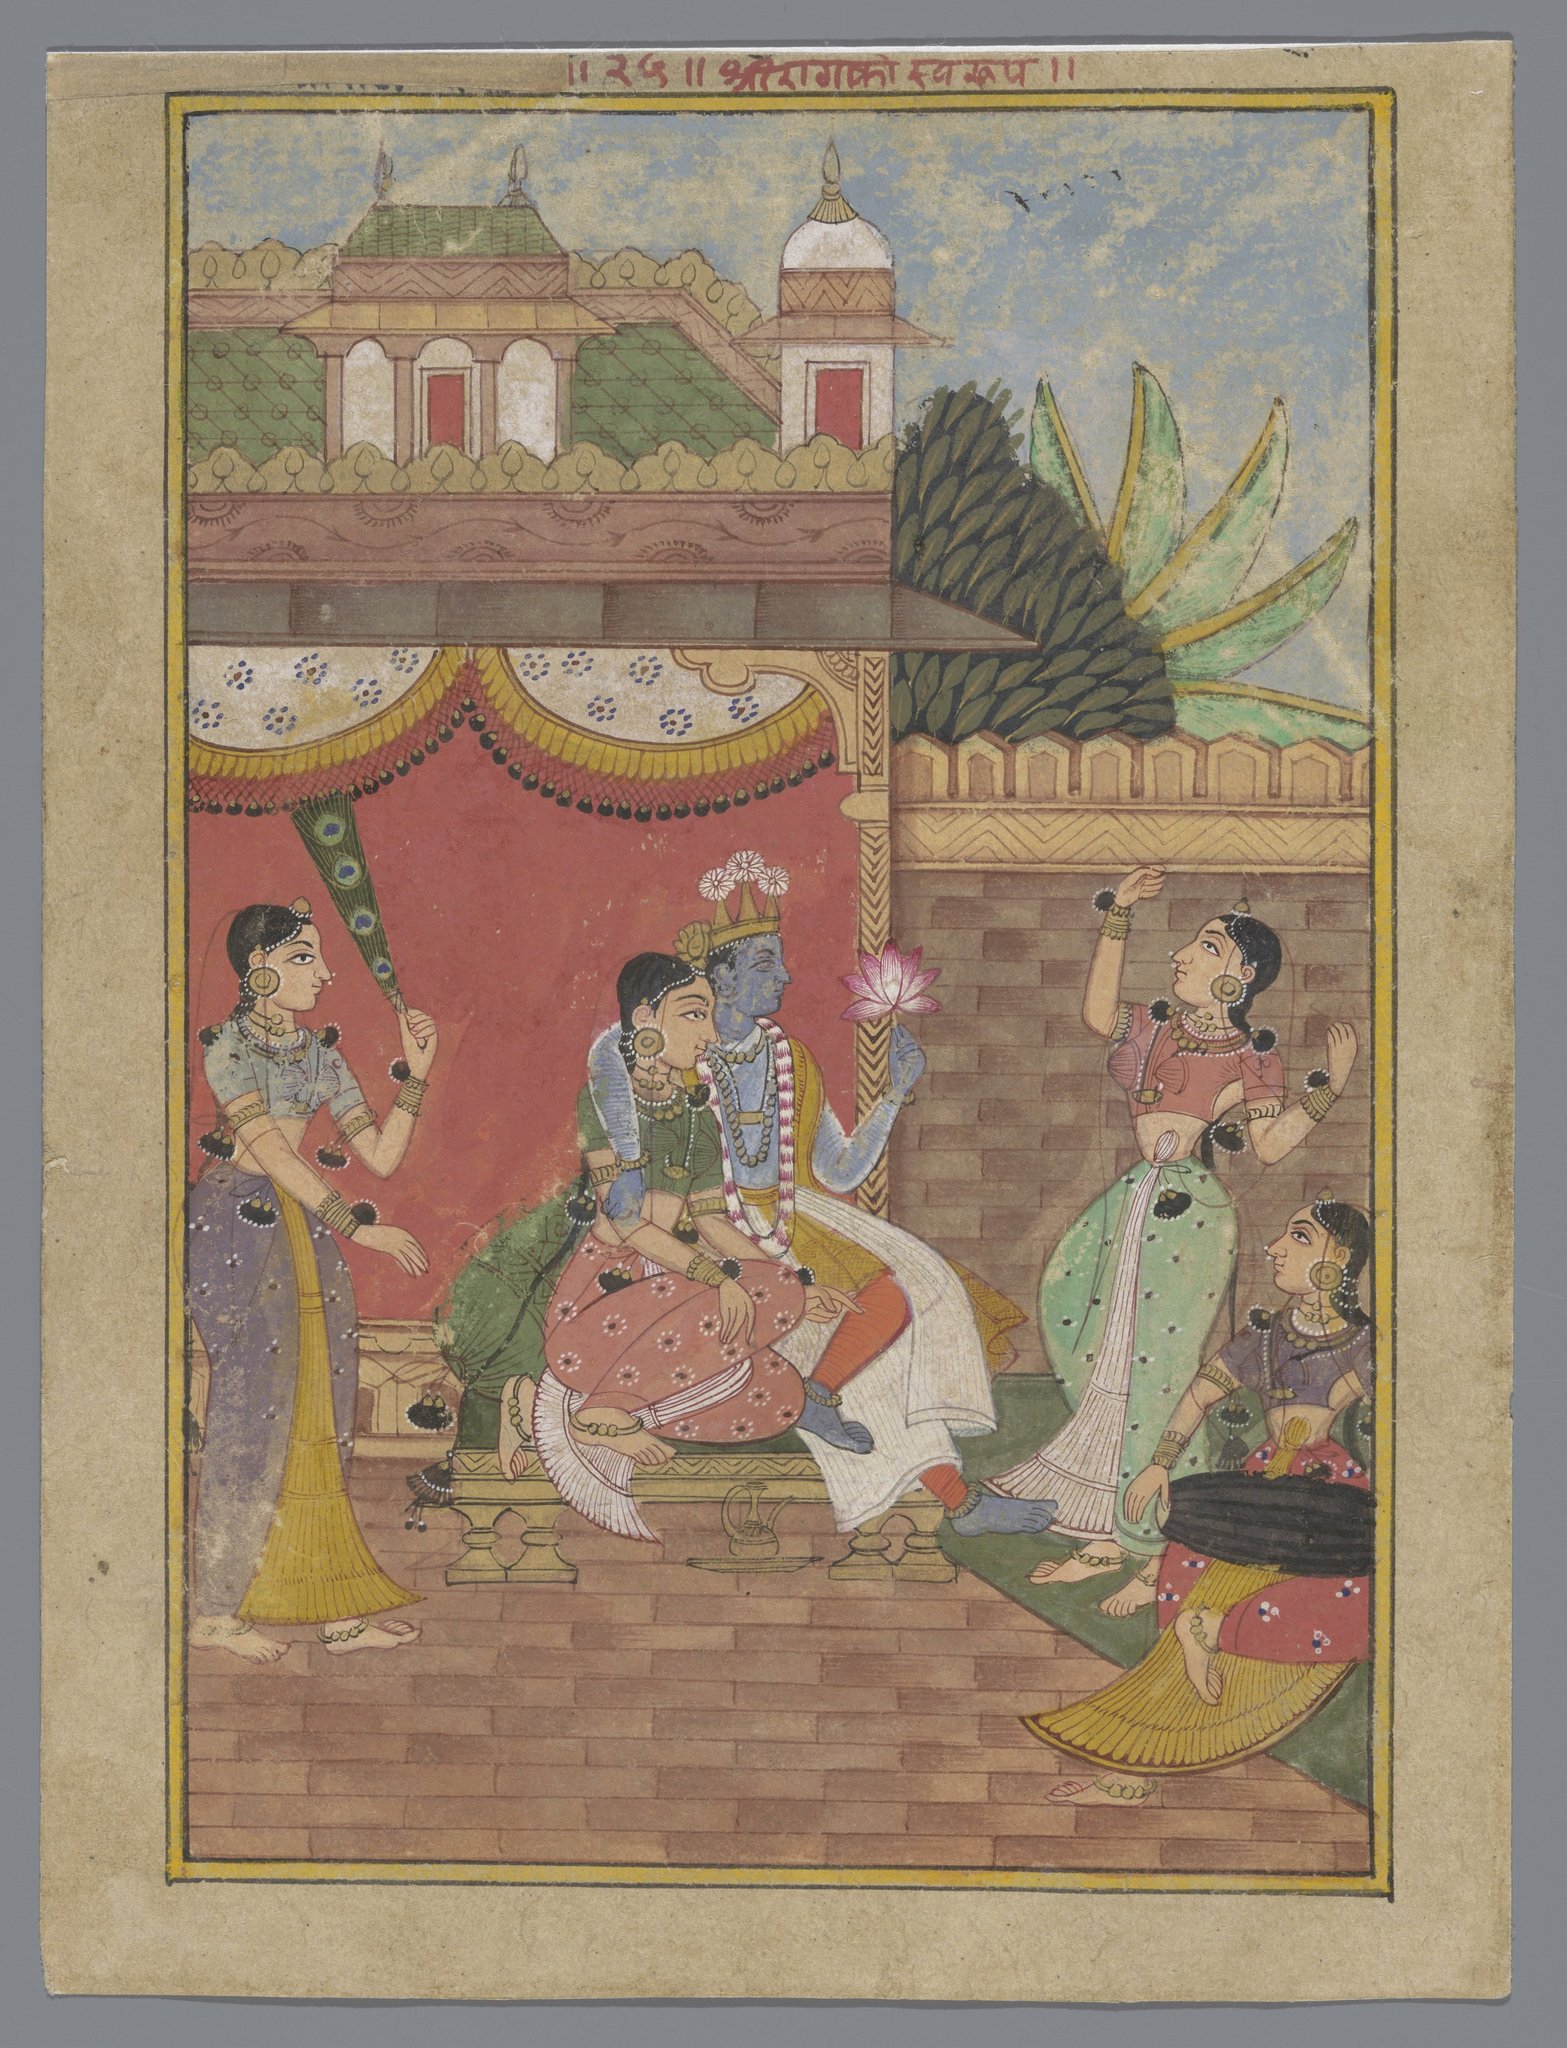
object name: drawing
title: Radha en Krishna in een paleis (Ragamala)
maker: Anonymous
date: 1610-1620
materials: paper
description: Radha en Krishna zitten op terras op een bankje. Krishna houdt een waterlelie in zijn linker hand en met zijn rechter hand omhelst hij Radha. Ze zijn omringd door drie vrouwen: een danseres, een vrouw die een drum bespeelt en een dienares met een waaier gemaakt uit pauwenveren. Boven de tekening een inscriptie in het Devanagari-schrift: Sri raagakii (raakhii?) svaruupa. No. 27. No. 27 uit de Ragamala-serie